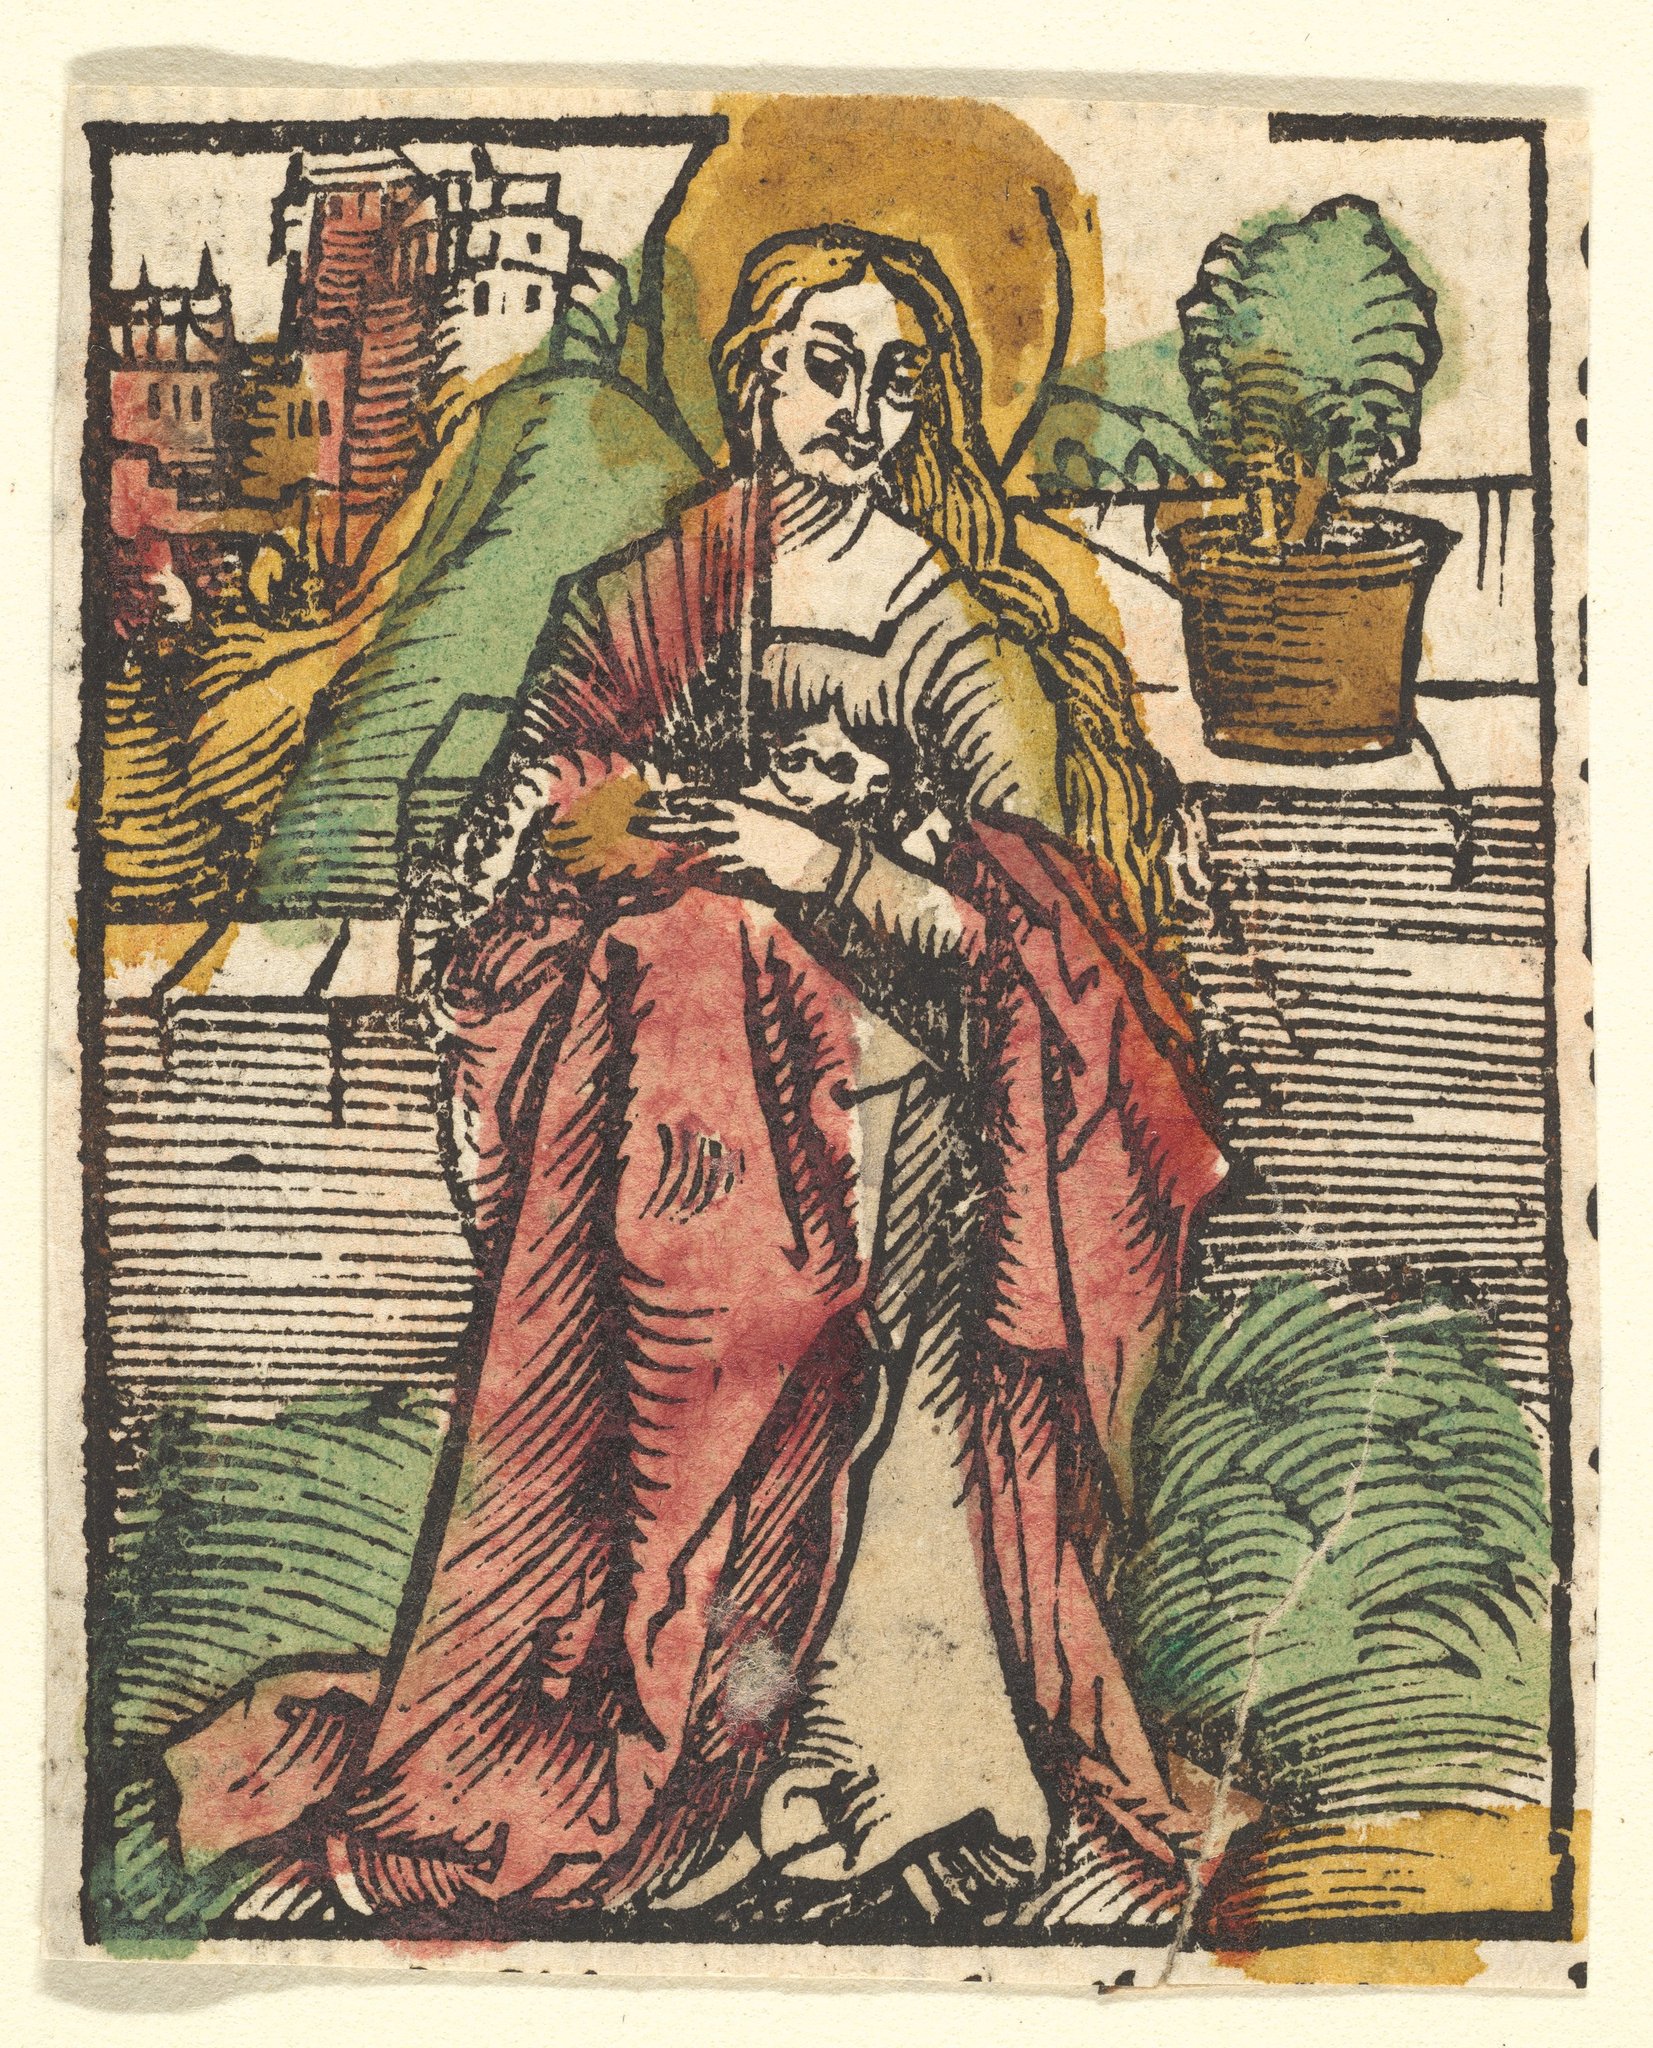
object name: print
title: St. Agnes (copy)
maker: hans baldung (called hans baldung grien)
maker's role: artist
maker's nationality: german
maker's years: 1484-1545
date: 1512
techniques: hand coloring, woodcut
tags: animals,women,saints